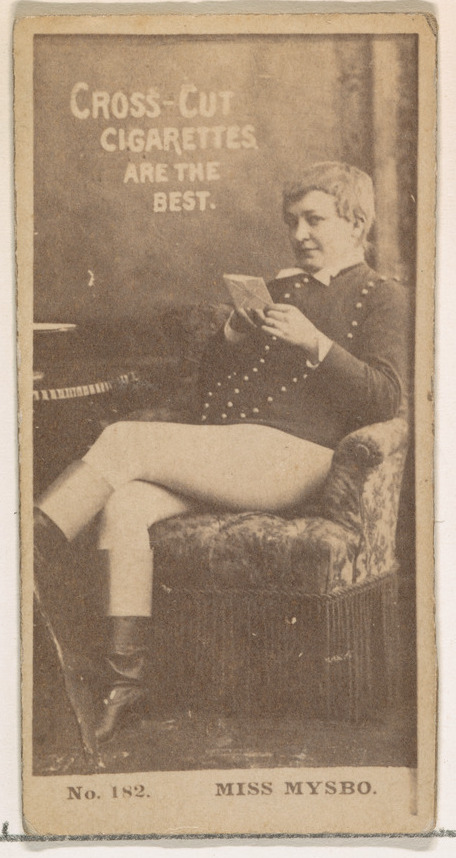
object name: print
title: Card Number 182, Miss Mysbo, from the Actors and Actresses series (N145-2) issued by Duke Sons & Co. to promote Cross Cut Cigarettes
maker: w. duke, sons & co.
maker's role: publisher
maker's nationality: american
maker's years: 1870-1920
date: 1880-1889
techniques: albumen silver print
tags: portraits,women,actresses